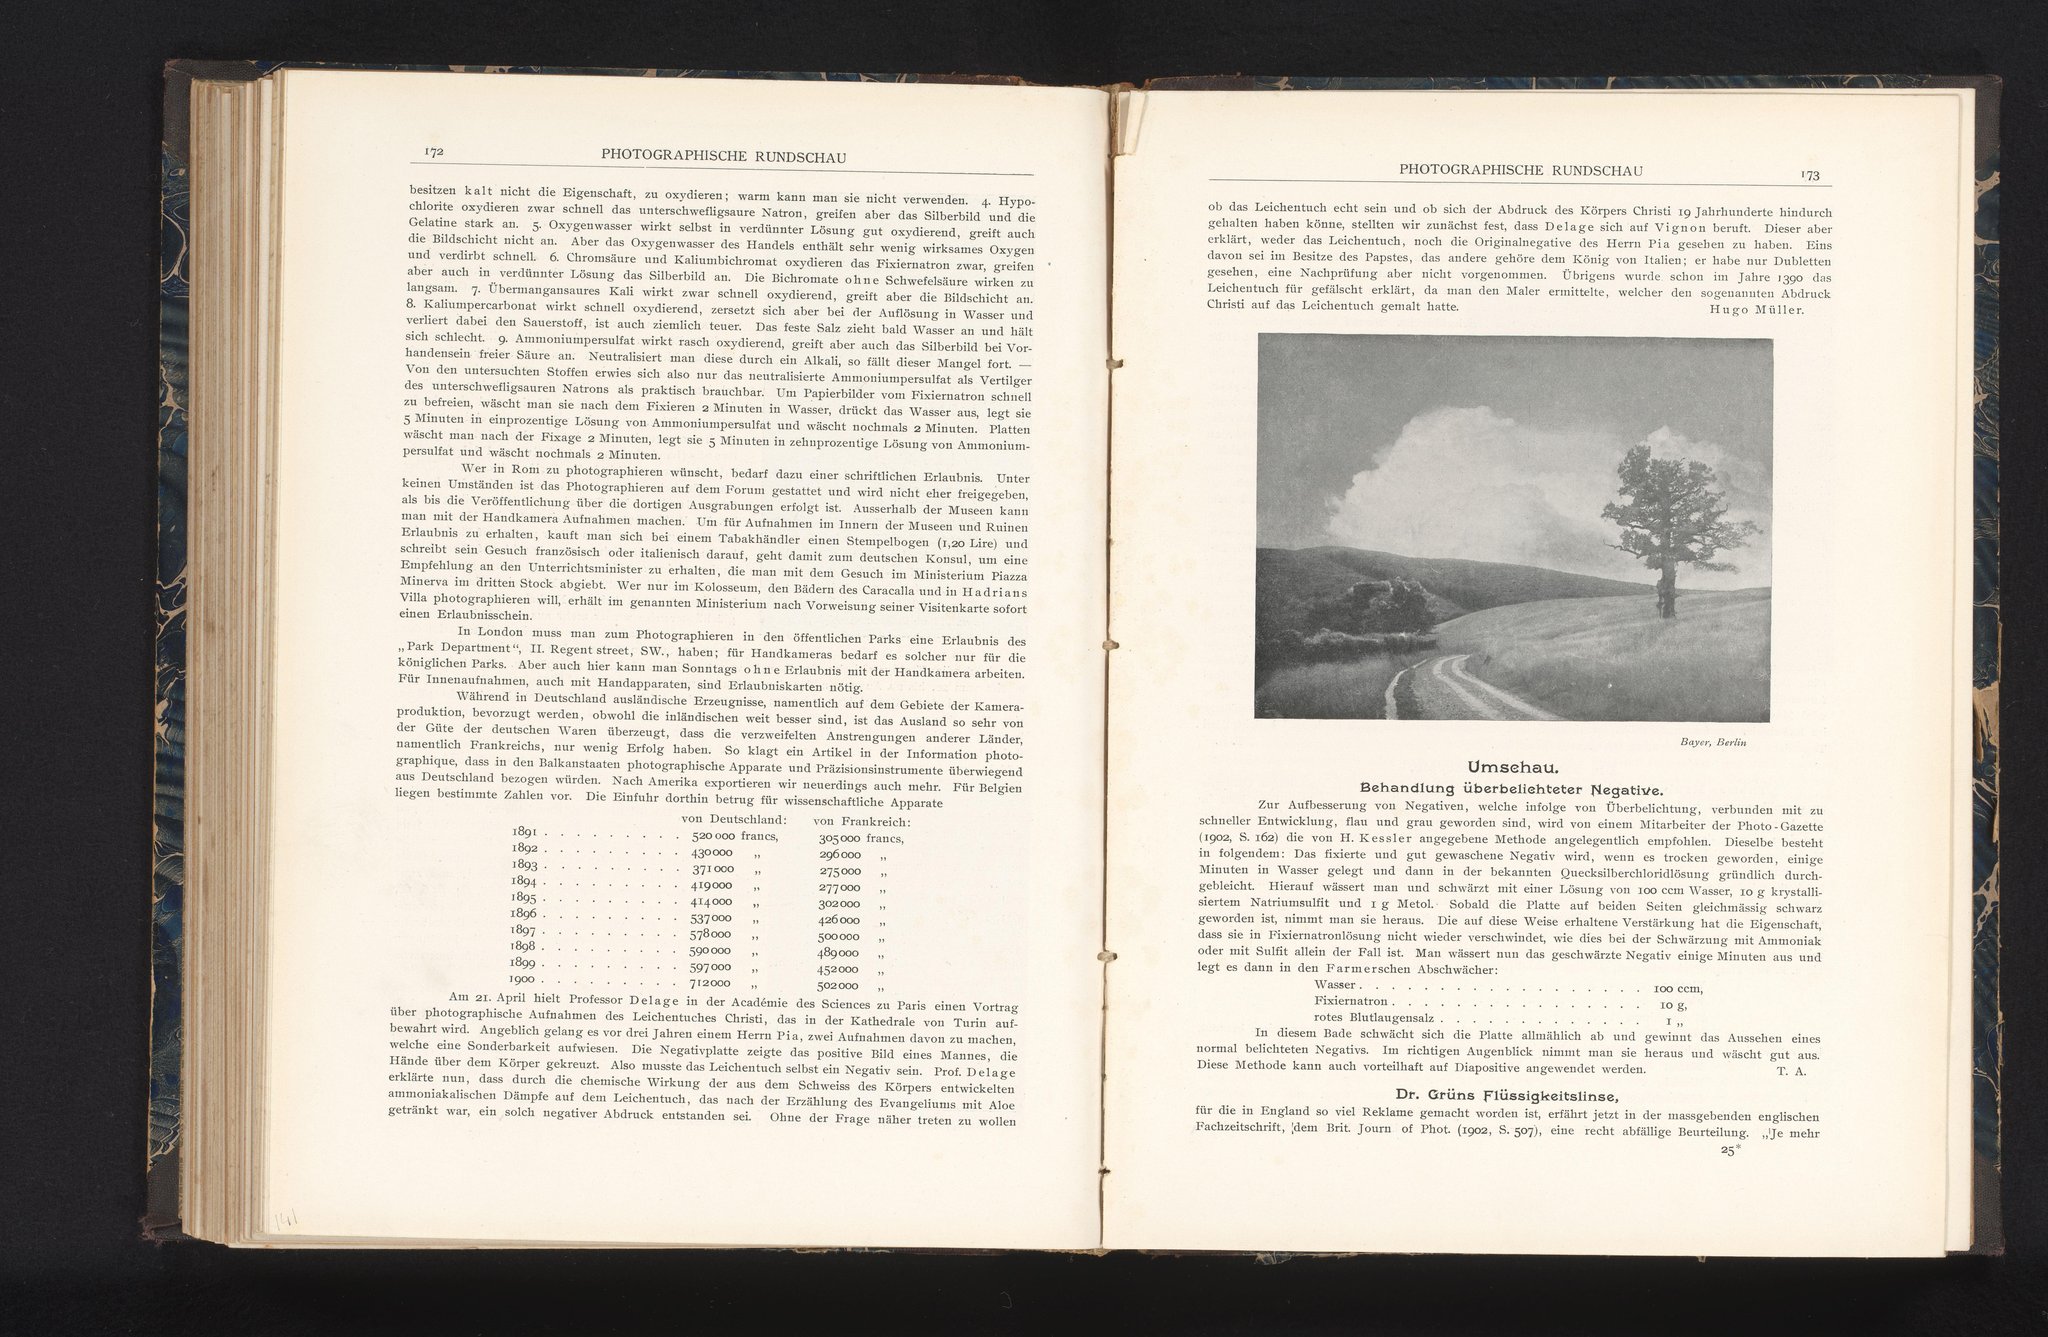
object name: photomechanical print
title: Gezicht op een boom en een pad door een landschap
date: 1897-1902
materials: paper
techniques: autotype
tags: trees, road, path